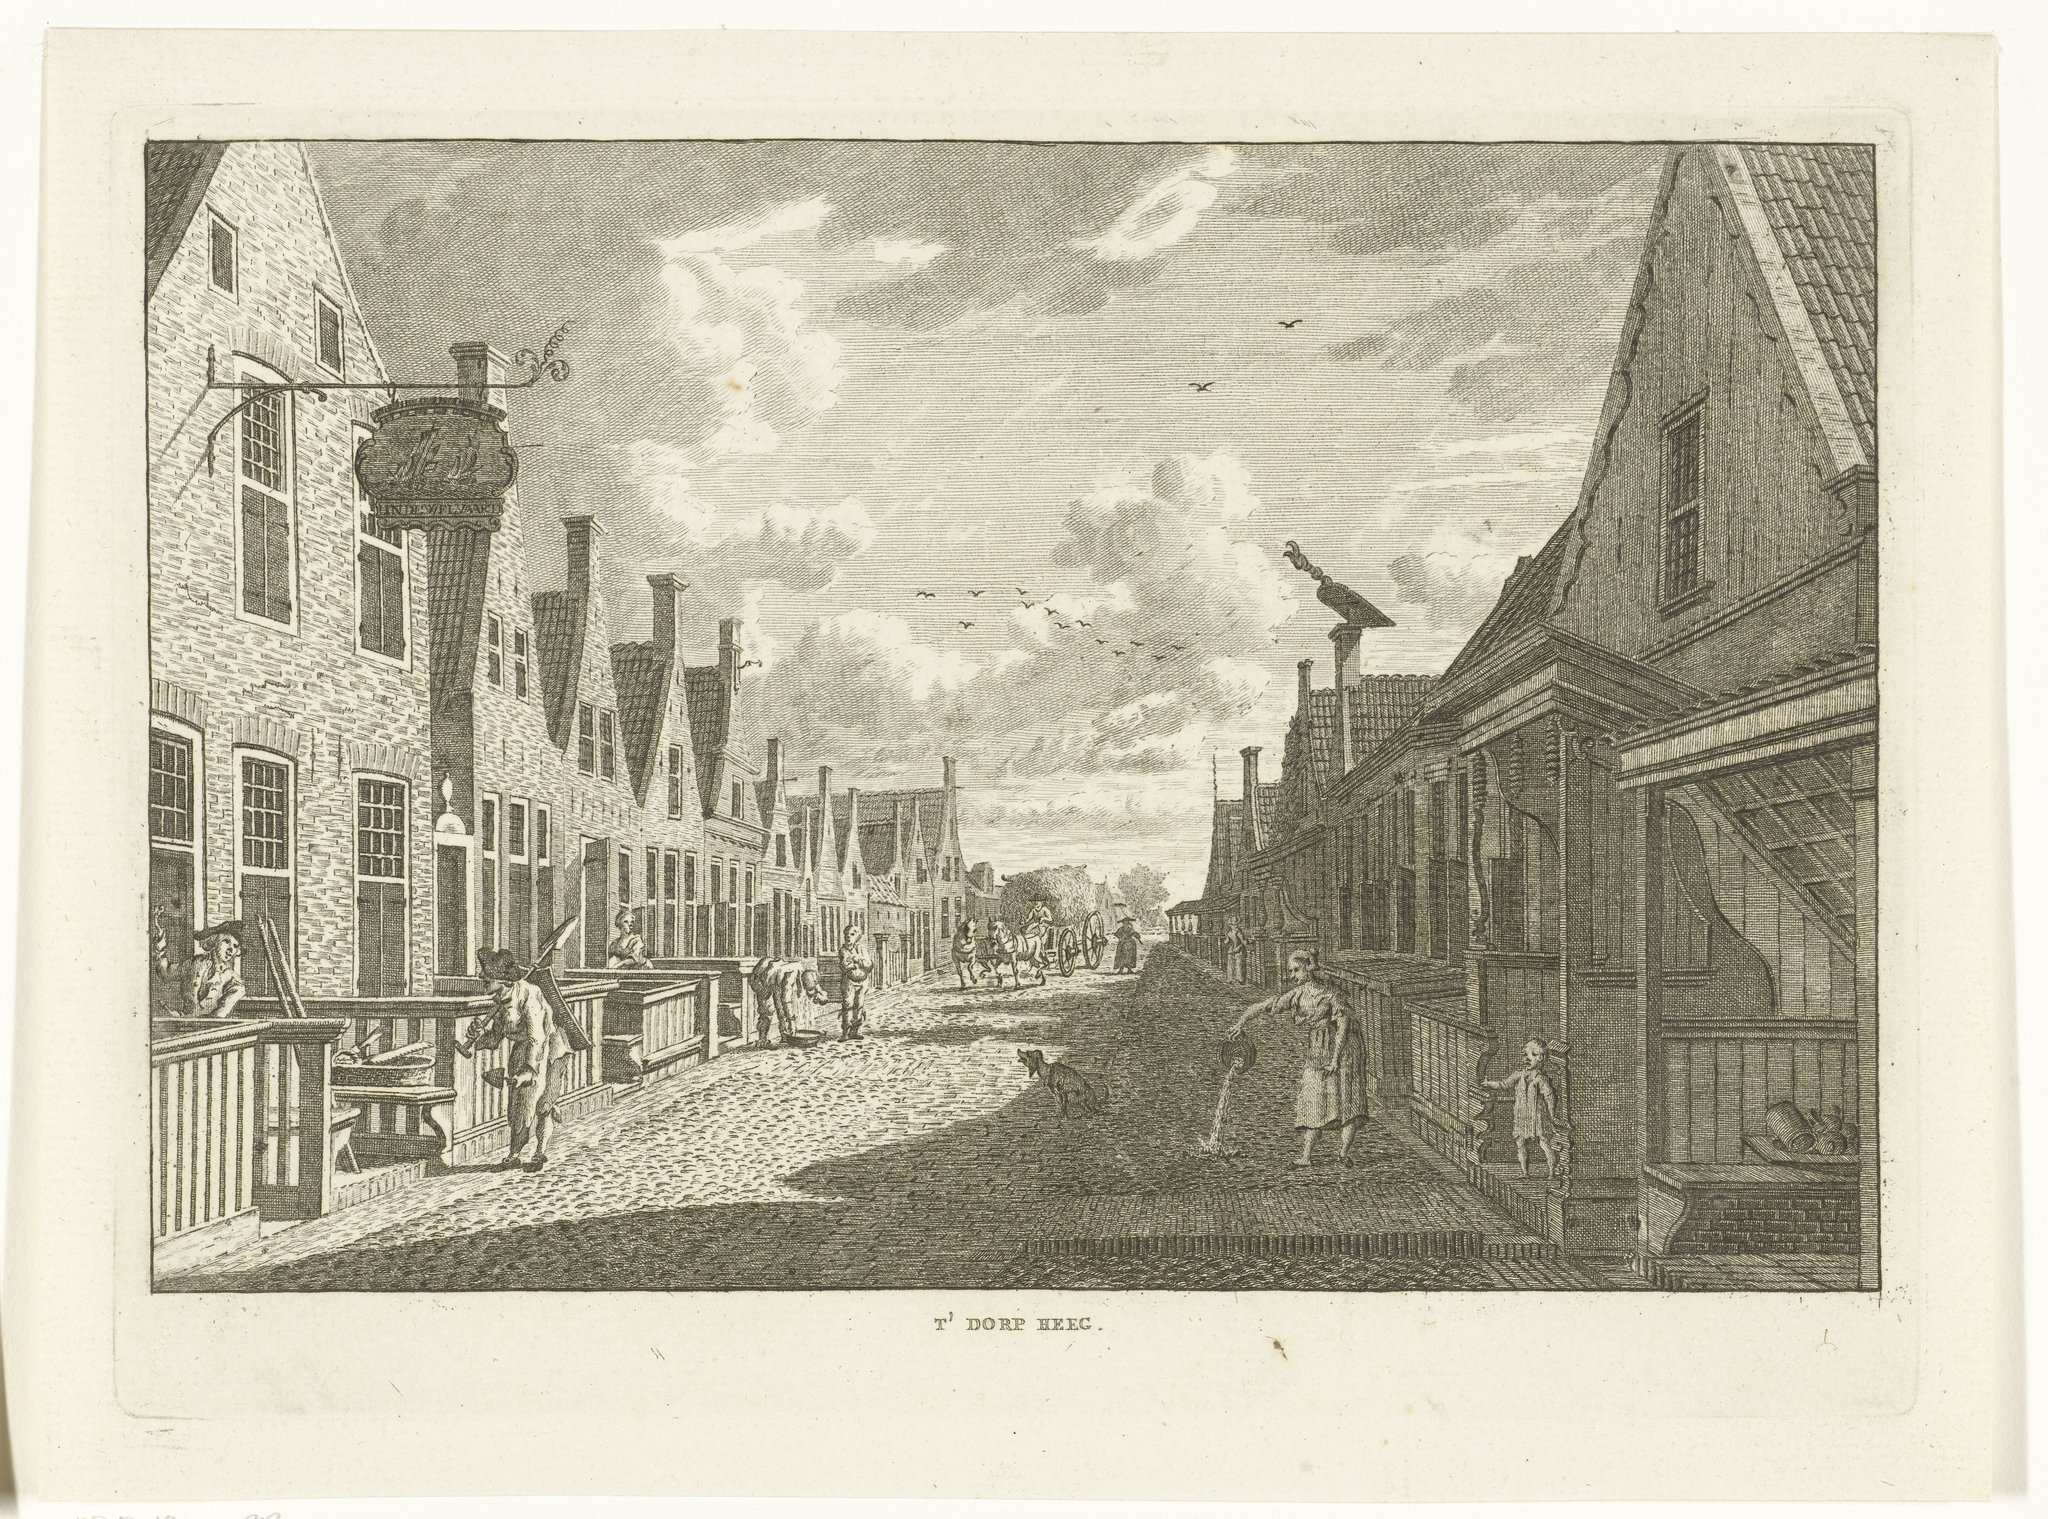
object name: print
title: T' Dorp Heeg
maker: carel frederik bendorp (i)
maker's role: print maker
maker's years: 1736-1814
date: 1786-1792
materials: paper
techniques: etching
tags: public road in village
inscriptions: collector's mark: Lugt 2228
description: Prent uit: Vaderlandsche gezichten, of afbeeldingen van den tegenwoordigen staat der Vereenigde Nederlanden (…). Amsterdam: Hendrik Gartman, Willem Vermandel en Jan Willem Smit, 1786-1792. Uitgegeven in afleveringen met ieder een eigen bifolium en inhoudsopgave. Alle prenten in deze publicatie zijn gegraveerd door Carel Frederik Bendorp (I) en, in de meeste gevallen, gebaseerd op tekeningen van Jan Bulthuis.